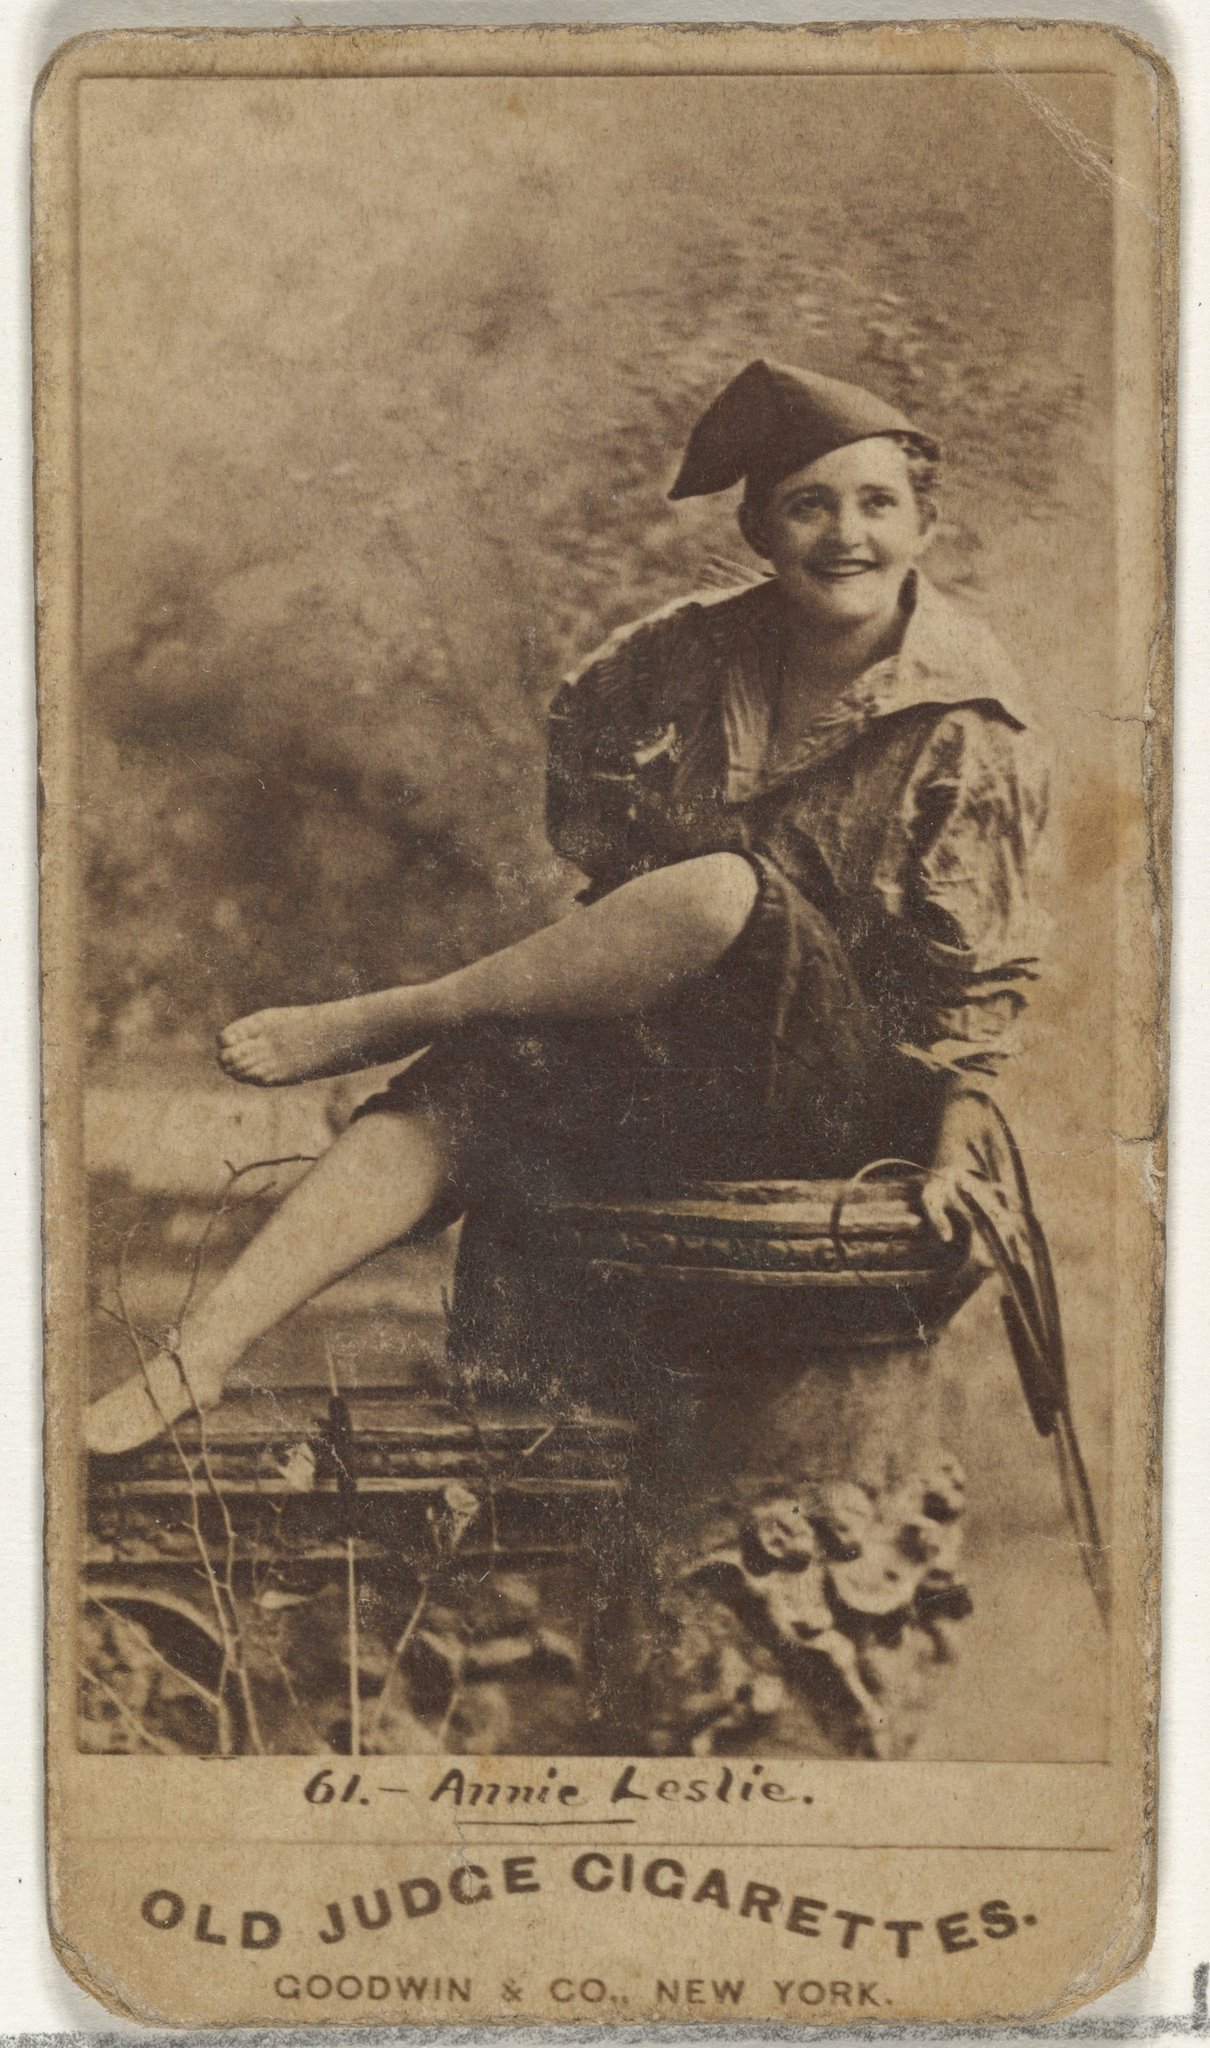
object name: photograph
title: Annie Leslie, from the Actors and Actresses series (N171) for Old Judge Cigarettes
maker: goodwin & company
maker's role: publisher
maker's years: 1850-1950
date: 1886-1890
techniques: albumen silver print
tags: portraits,women,actresses